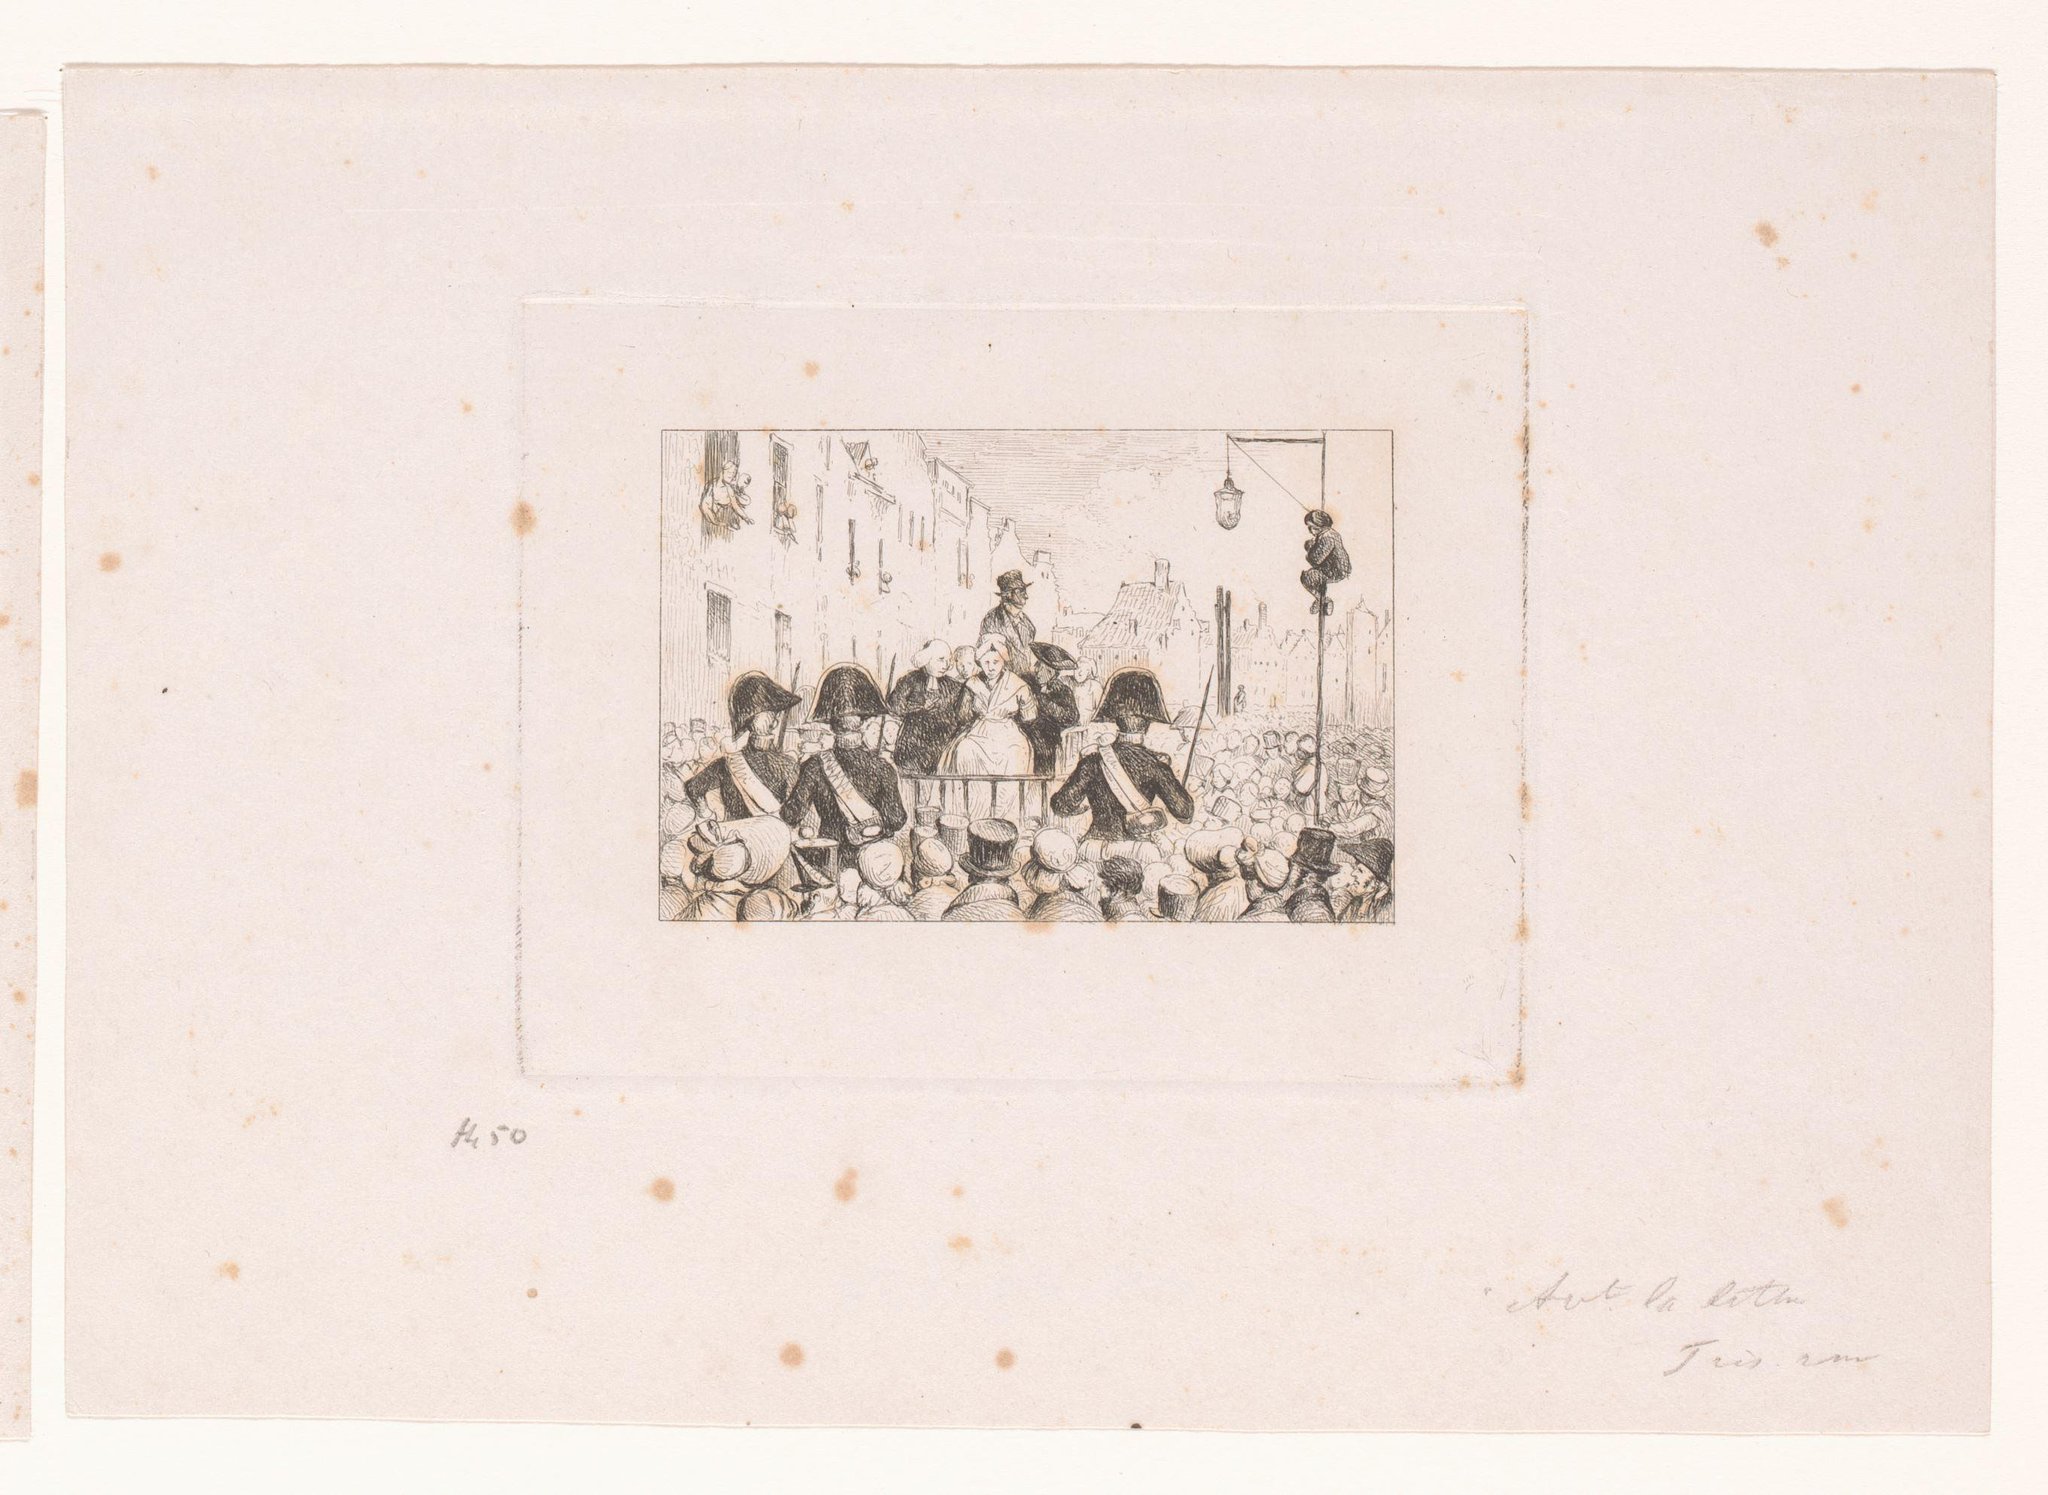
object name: book illustration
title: Veroordeelde vrouw op een kar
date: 1830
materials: paper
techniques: etching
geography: paris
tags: (person under sentence of death) on the way to the scaffold or place of execution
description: Prent uit: Monnier, Henry. Scènes populaires, dessinées à la plume. Parijs: Levavasseur, 1830.